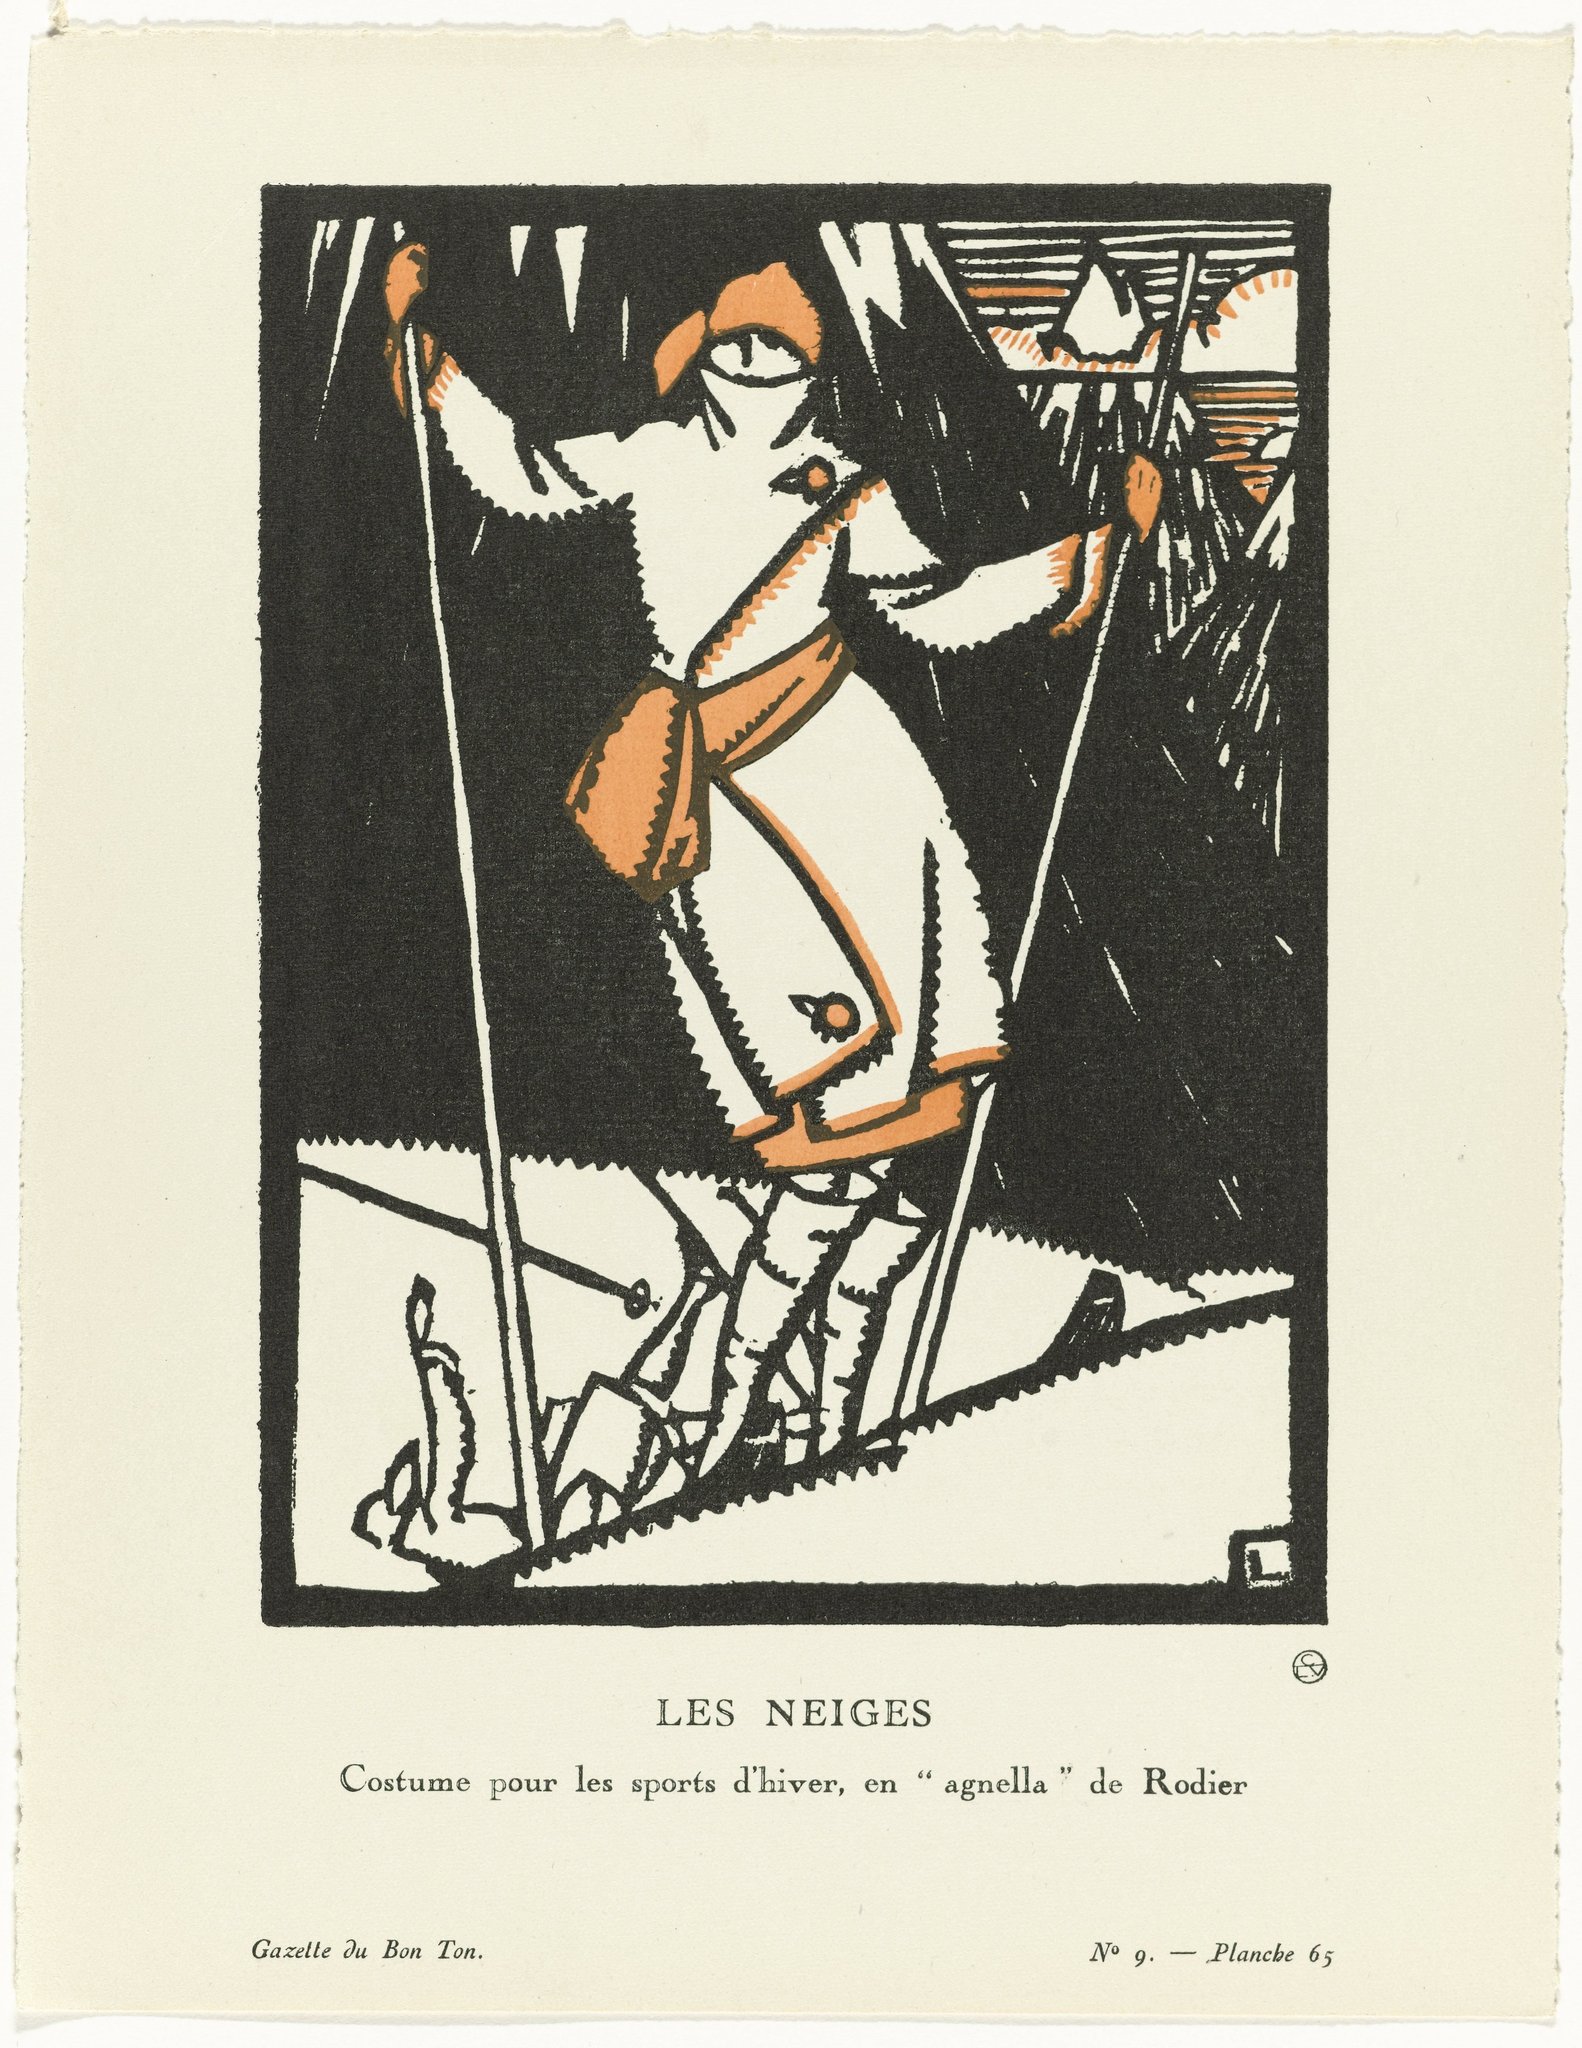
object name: fashion print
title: Gazette du Bon Ton, 1920 - No. 9, Pl. 65 : Les Neiges / Costume pour les sports d'hiver, en"agnella" de Rodier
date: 1920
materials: paper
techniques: letterpress printing, pochoir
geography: london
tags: clothing for the upper part of the body (+ women's clothes), ornamental parts of clothing (+ women's clothes), coat (+ women's clothes), fashion plates, skirt (+ women's clothes)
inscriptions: date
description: Vrouw op ski's, gekleed in wintersportkleding van Rodier, bestaande uit een mantel met knopen van galaliet. Planche 65 uit Gazette du Bon Ton 1920, No. 9. Uitleg over de kleding op pagina "Explication des Planches".